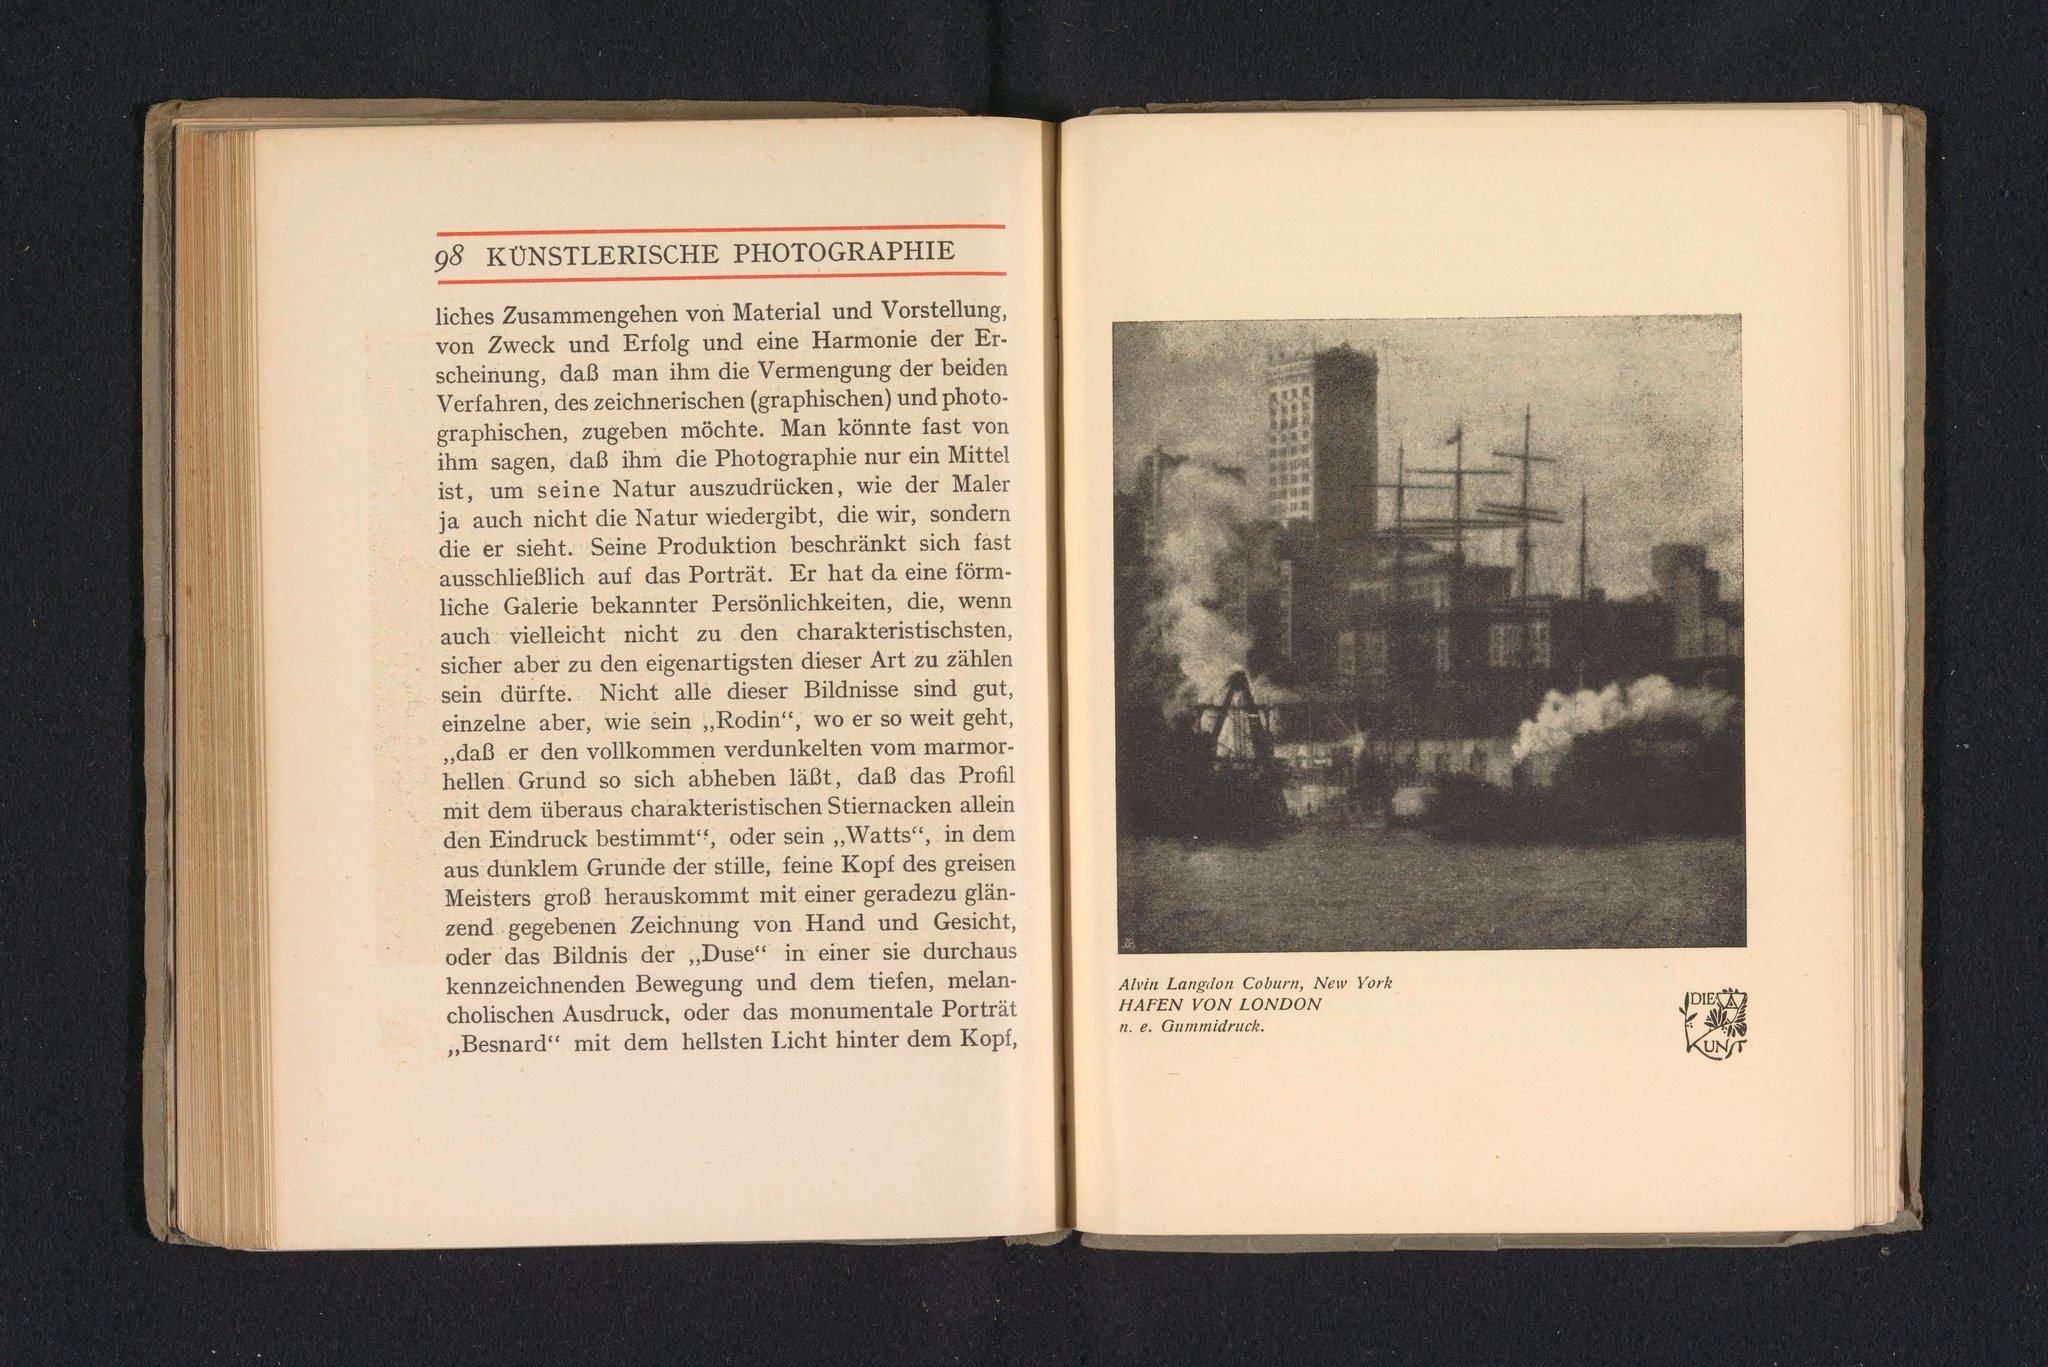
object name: reproduction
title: Fotoreproductie van een foto door Alvin Langdon Coburn, voorstellend de haven van Londen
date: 1880-1907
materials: paper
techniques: autotype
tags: harbour, london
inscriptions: inscription: ‘n.e. Gummidruck.’